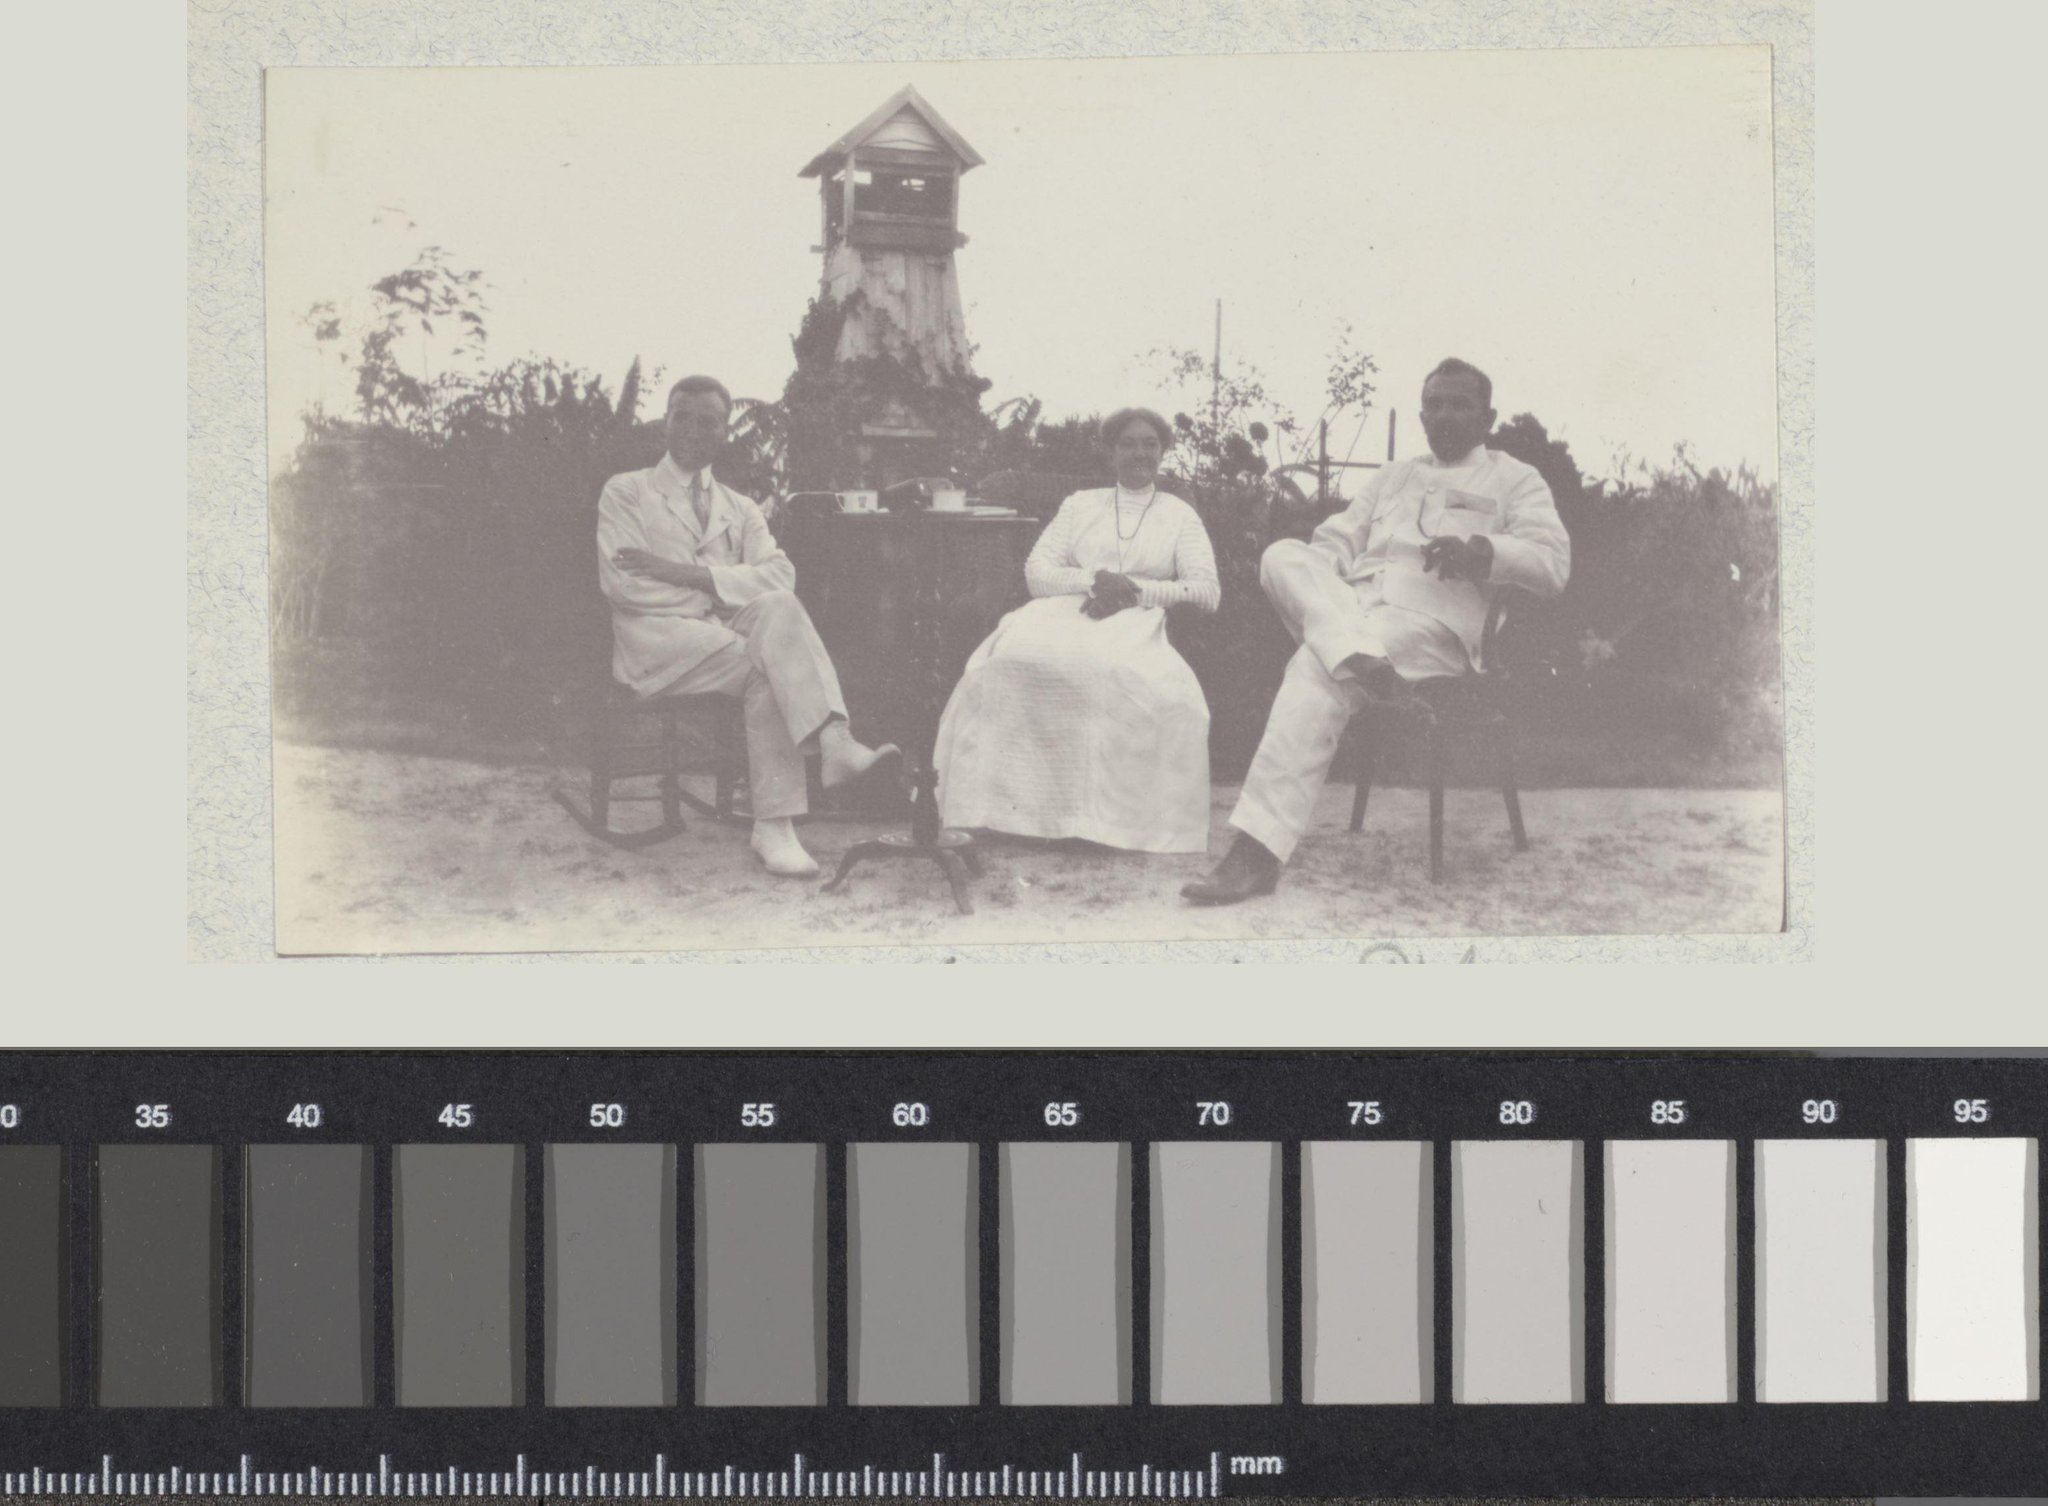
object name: photograph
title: Andries Boom, Justus Gonggrijp en Anna Gonggrijp-Rühmann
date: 1910-1911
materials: photographic support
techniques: photography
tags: andries augustus boom, dutch east indies, the, justus gonggrijp, suriname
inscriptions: inscription: ‘Clevia. october '11. P'bo.’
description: Andries Boom met zijn toekomstige schoonouders Justus Gonggrijp Anna Gonggrijp-Rühmann zittend op Plantage Clevia, oktober 1911. Onderdeel van het fotoalbum van de familie Boom-Gonggrijp in Suriname en Curaçao.